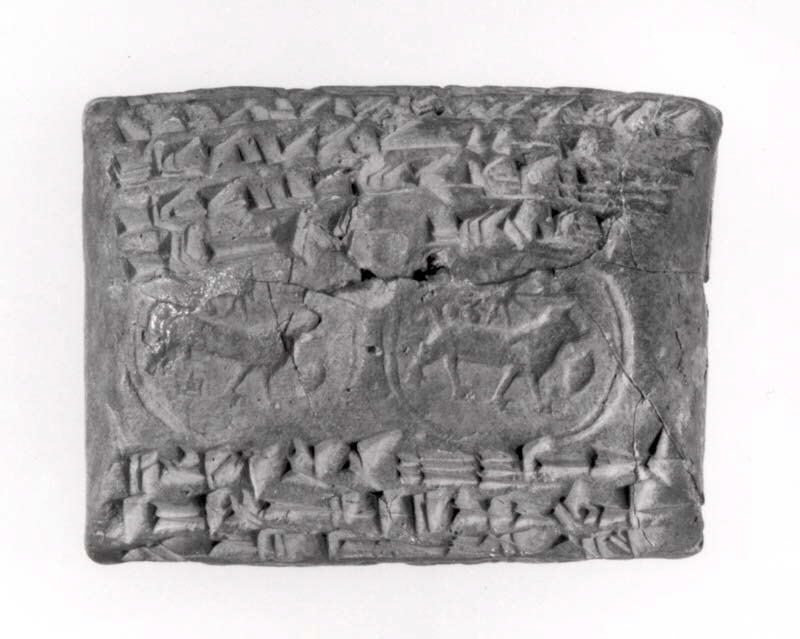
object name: cuneiform tablet case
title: Cuneiform tablet case impressed with stamp seal, for cuneiform tablet 54.117.27b: loan of silver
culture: assyrian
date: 700-601 BCE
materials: clay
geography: mesopotamia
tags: animals